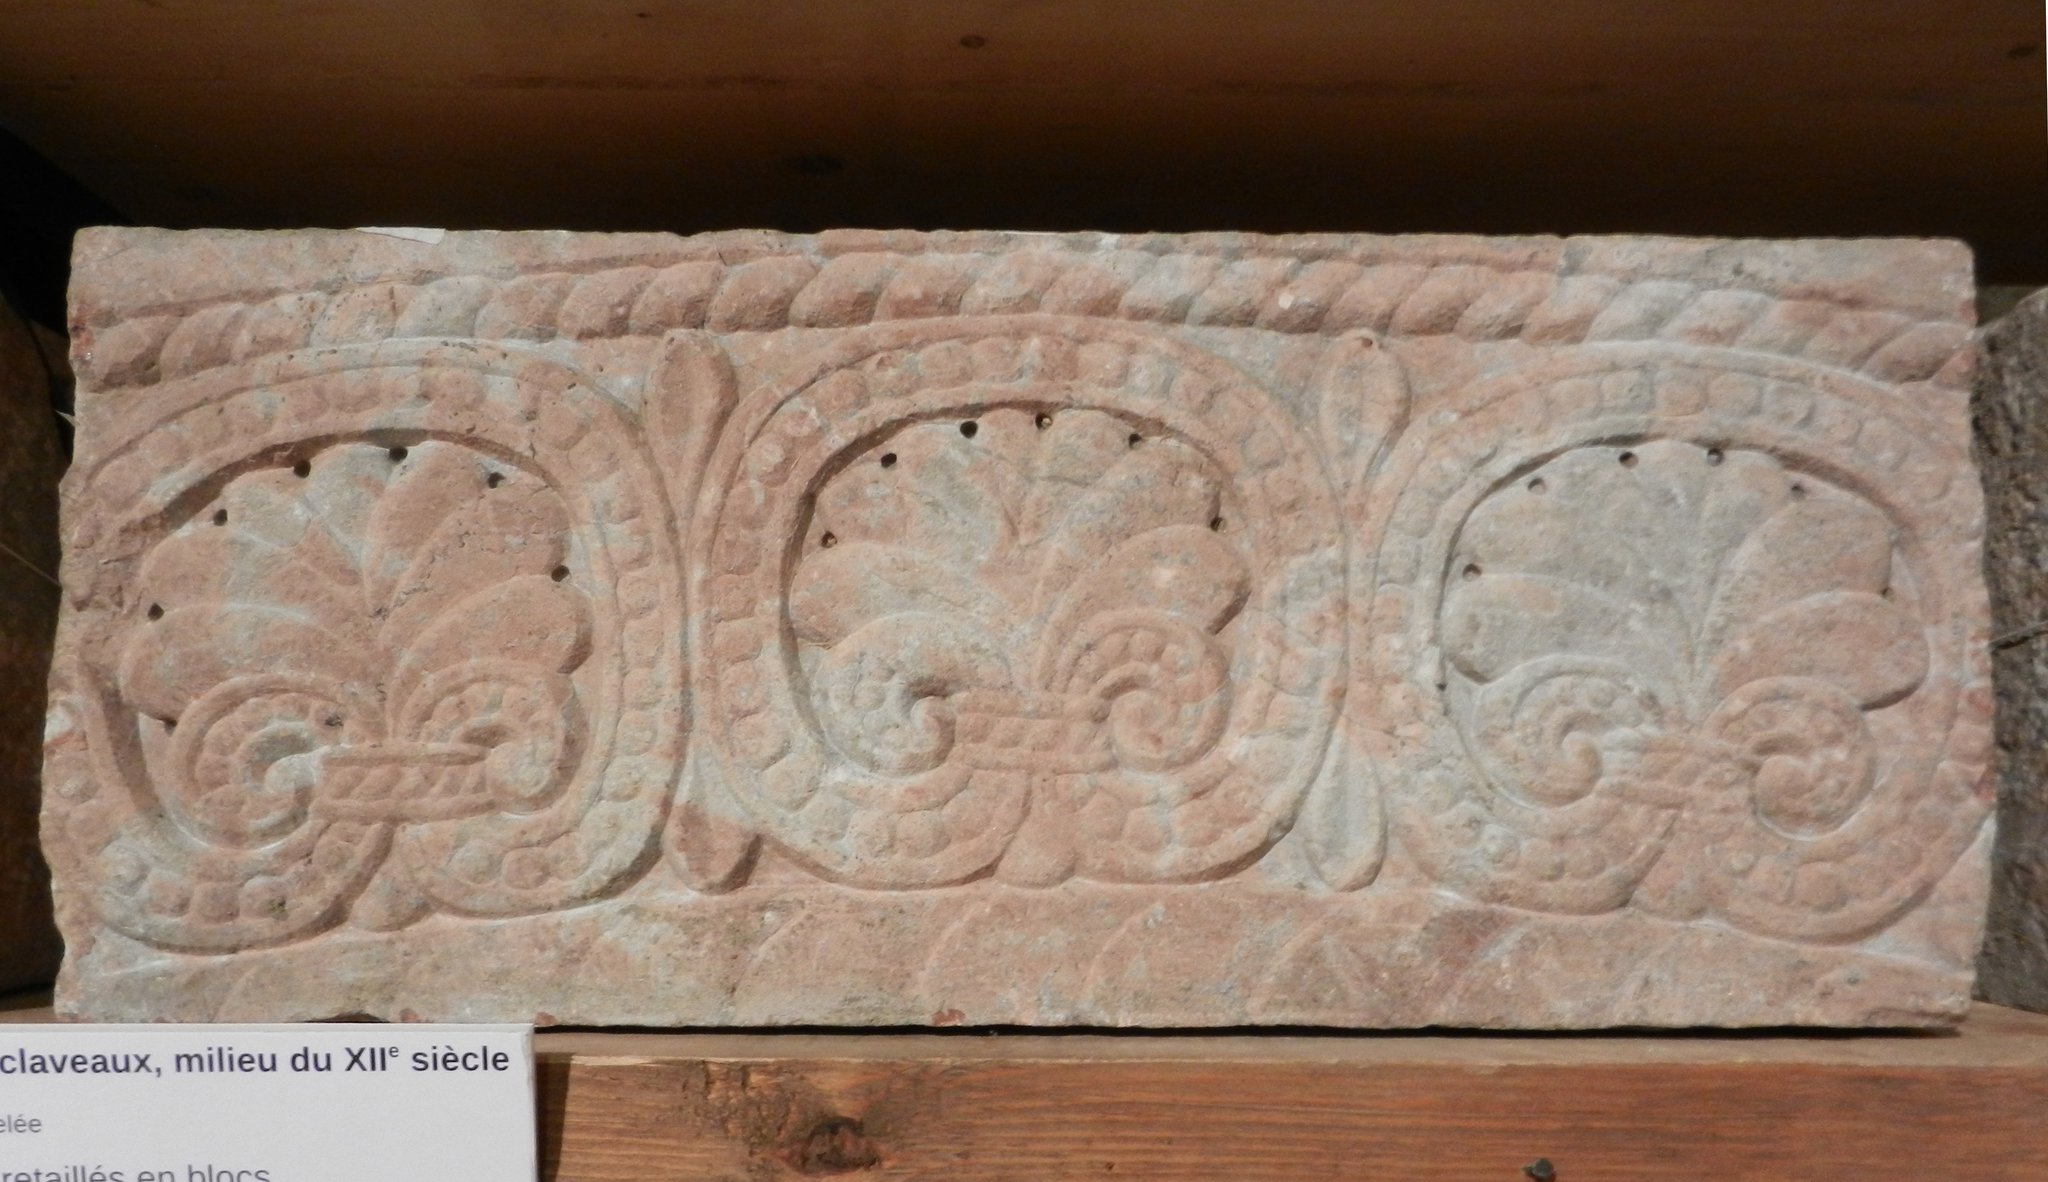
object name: fragment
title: Lintel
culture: catalan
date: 1130-1140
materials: marble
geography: france